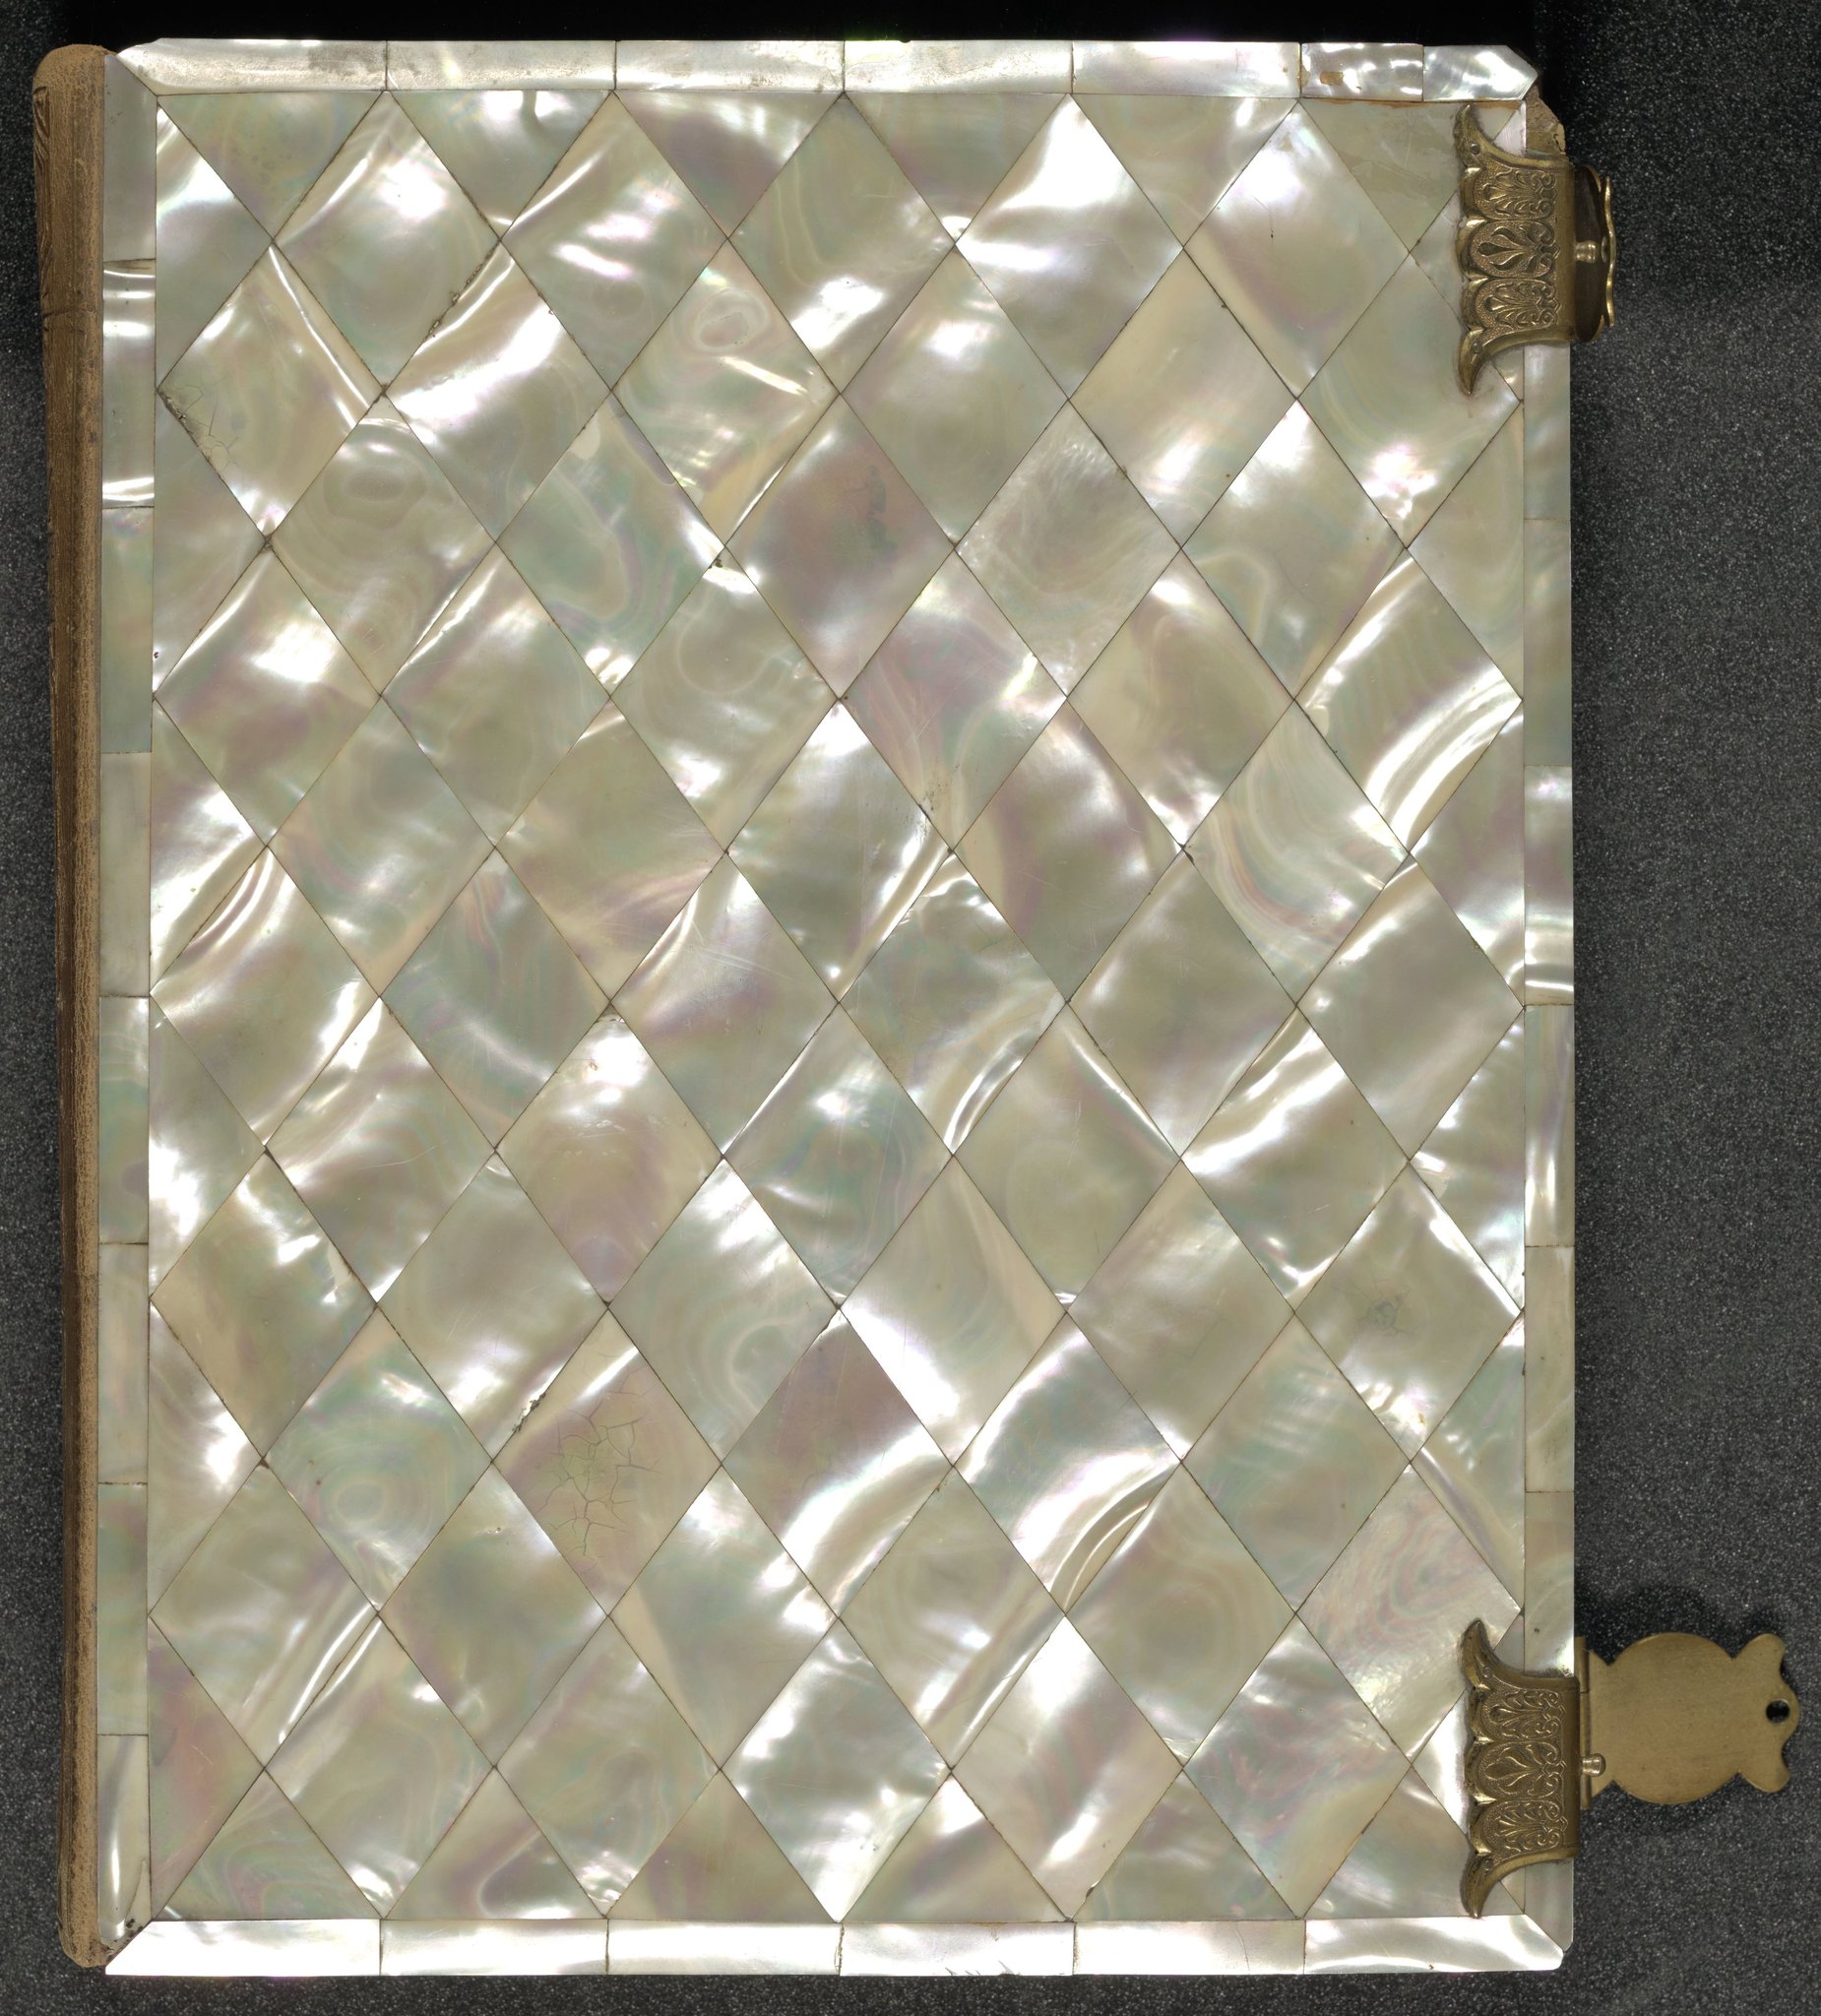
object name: photograph album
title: Photographic Album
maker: l.j. hartkamp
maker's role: advocaat, fotograaf, kunstverzamelaar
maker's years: 1916-1999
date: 1860-1900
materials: cardboard, leather, metal, mother of pearl, paper, photographic support, textile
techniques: albumen print, lithograph, hand coloring, letterpress printing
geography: netherlands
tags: historical persons, politician, e.g. party leader, ruler, sovereign, organization, functionaries and dignitaries in roman catholic church; clergy in general, politics, europe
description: Fotoalbum in omslag van parelmoer met twee metalen sloten. Rug van leer met daarop het woord 'Album' in blindstempel. Voorin het album een titelpagina met daarop in gouddruk de woorden 'Photographic Album'. Deze wordt gevolgd door een pagina met een (onbeschreven) index van namen. Het album bevat 19 insteekbladen met goud op snee. Daarin in totaal 123 cartes-de-visite, waarvan één los in een hoesje. Het album is leeg aangekocht door verzamelaar L.J. Hartkamp en door hem gevuld met cartes-de-visite. Bij het merendeel heeft hij op het insteekblad de naam van de fotograaf geschreven alsmede personalia, functies en familierelaties van de afgebeelde persoon. Het betreft cartes-de-visite (vaak naar een prent) van onder meer leden van Franse, Duitse, Belgische en Nederlandse vorstenhuizen en Europese politici als Bismarck, Gladstone en Garibaldi. Ook foto's van geestelijken, vrijheidsstrijders en bekende personen van buiten Europa waaronder de sjah van Perzië.